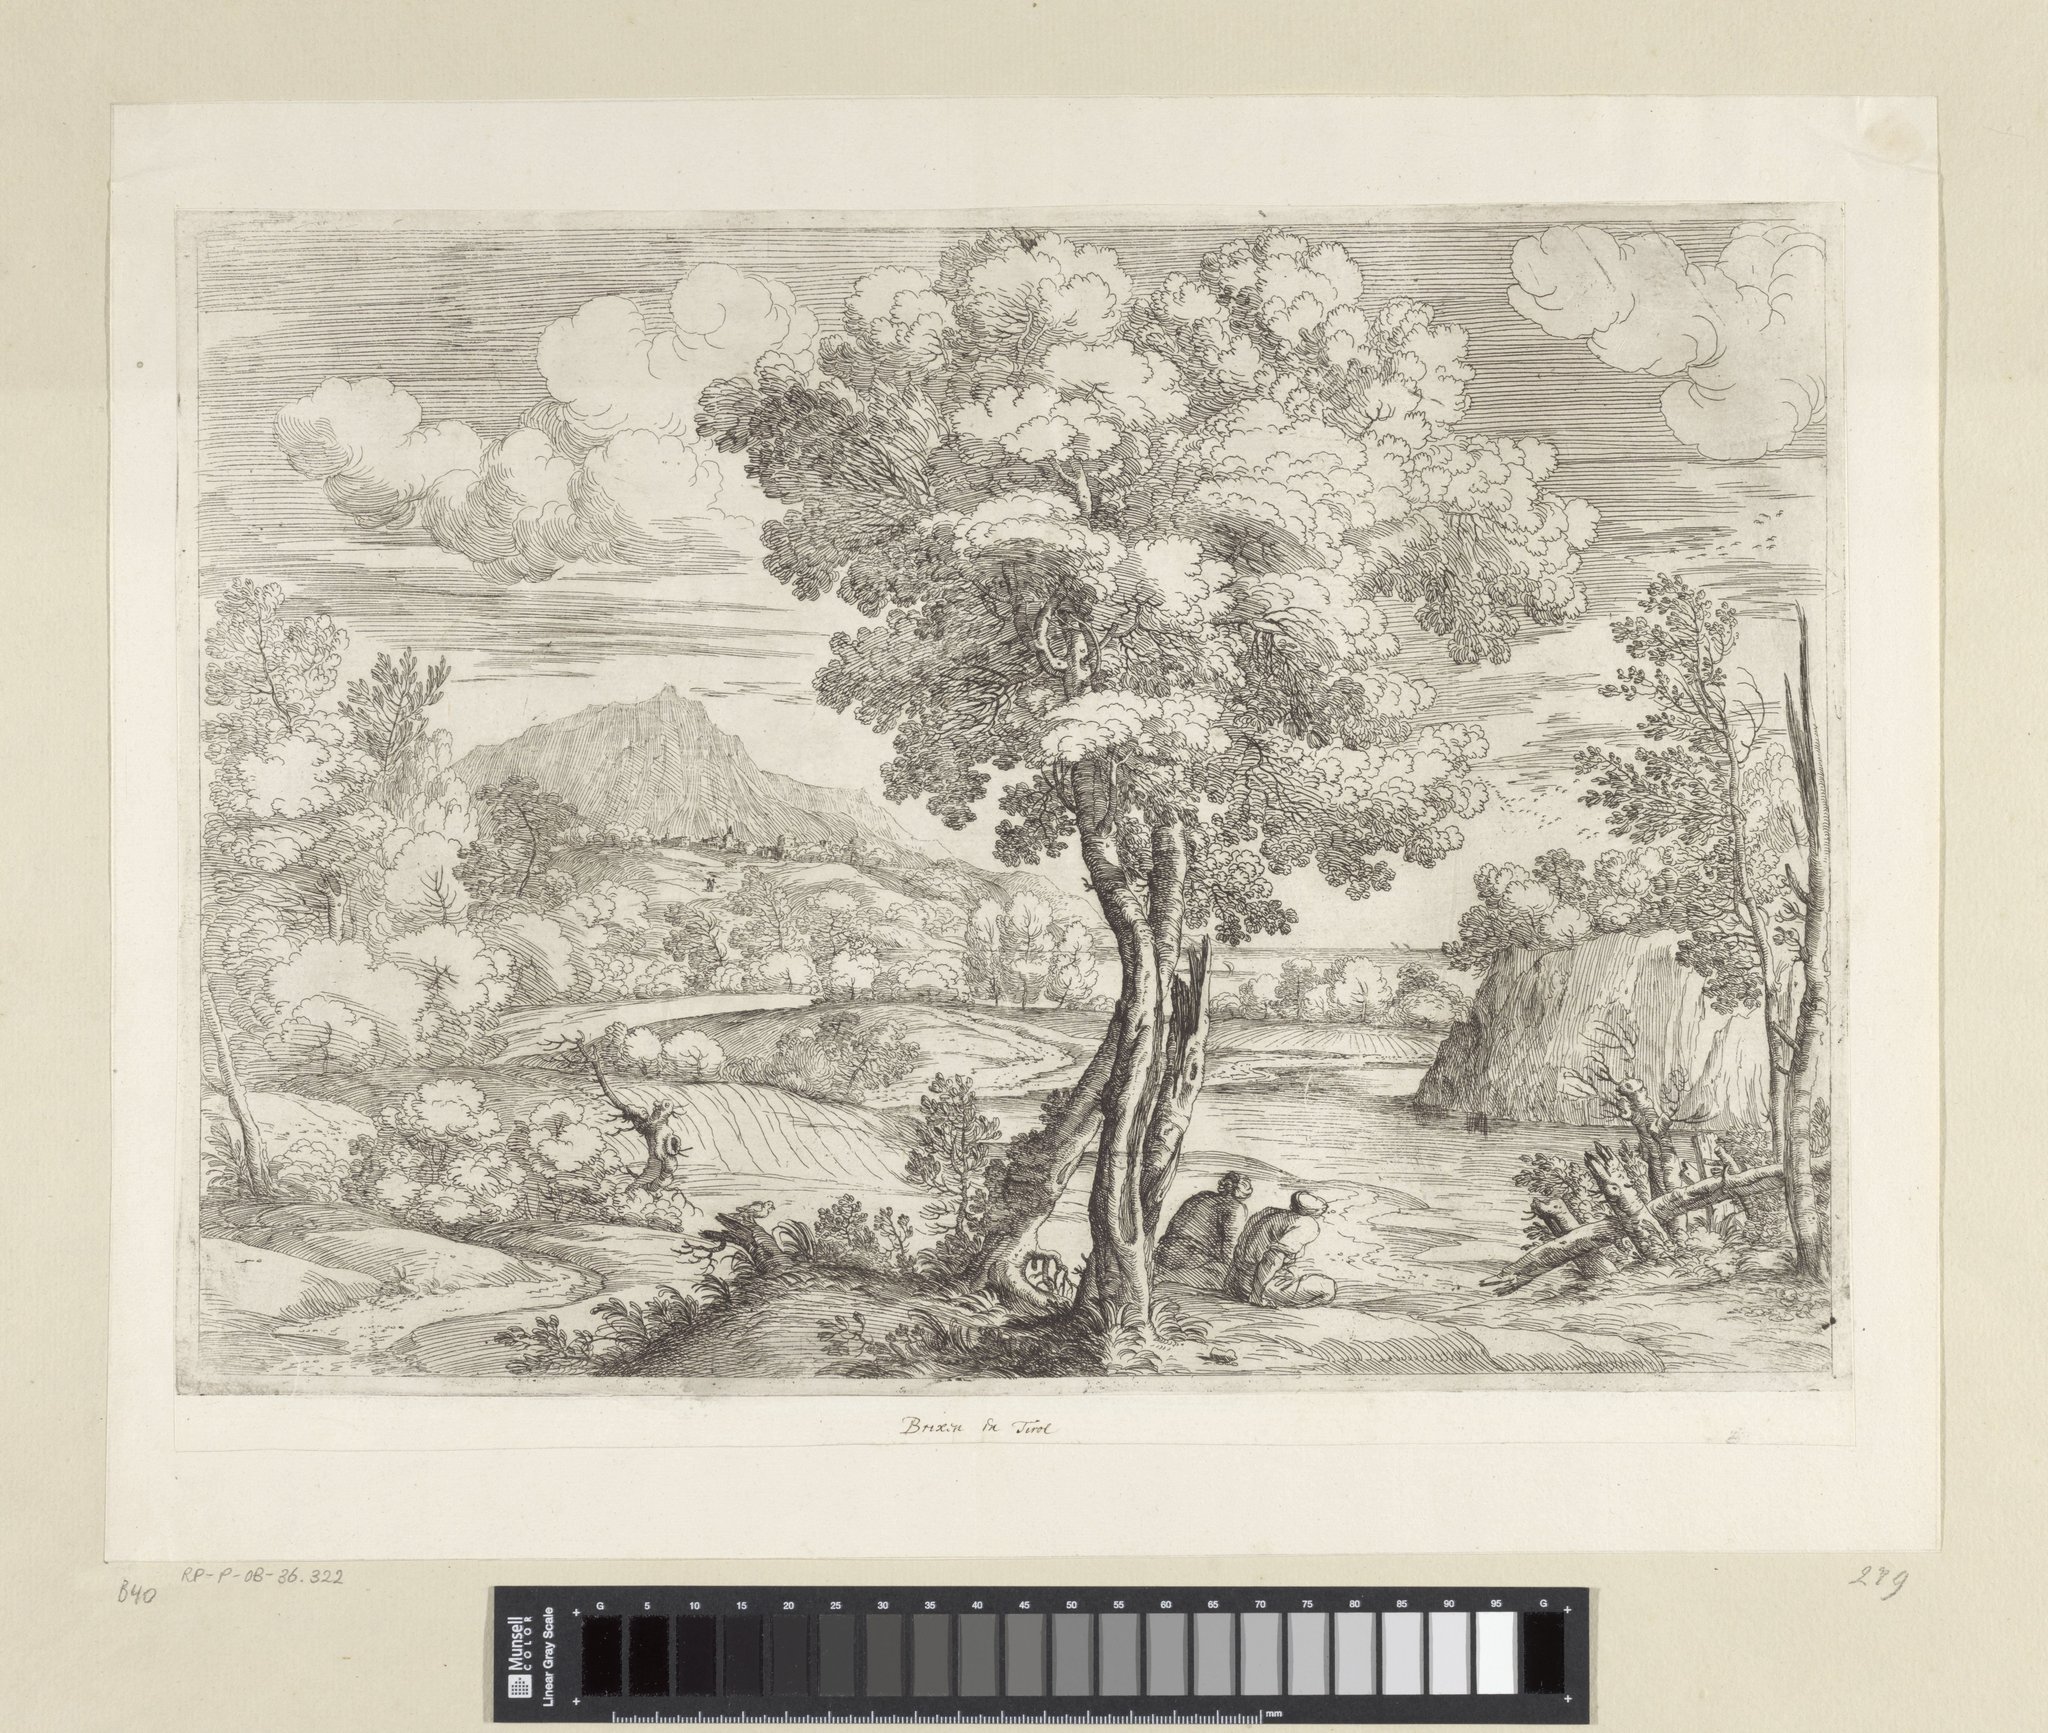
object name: print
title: Landschap met vogel op boomstronk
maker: giovanni francesco grimaldi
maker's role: draughtsman, print maker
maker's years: 1606-1680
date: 1616-1680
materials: paper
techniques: etching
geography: italy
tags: landscapes, river, birds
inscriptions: inscription: ‘B[...] in Tirol’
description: Een weids landschap met heuvels en een rivier. Op de voorgrond een vogel op een boomstronk en twee mannen aan de waterkant.